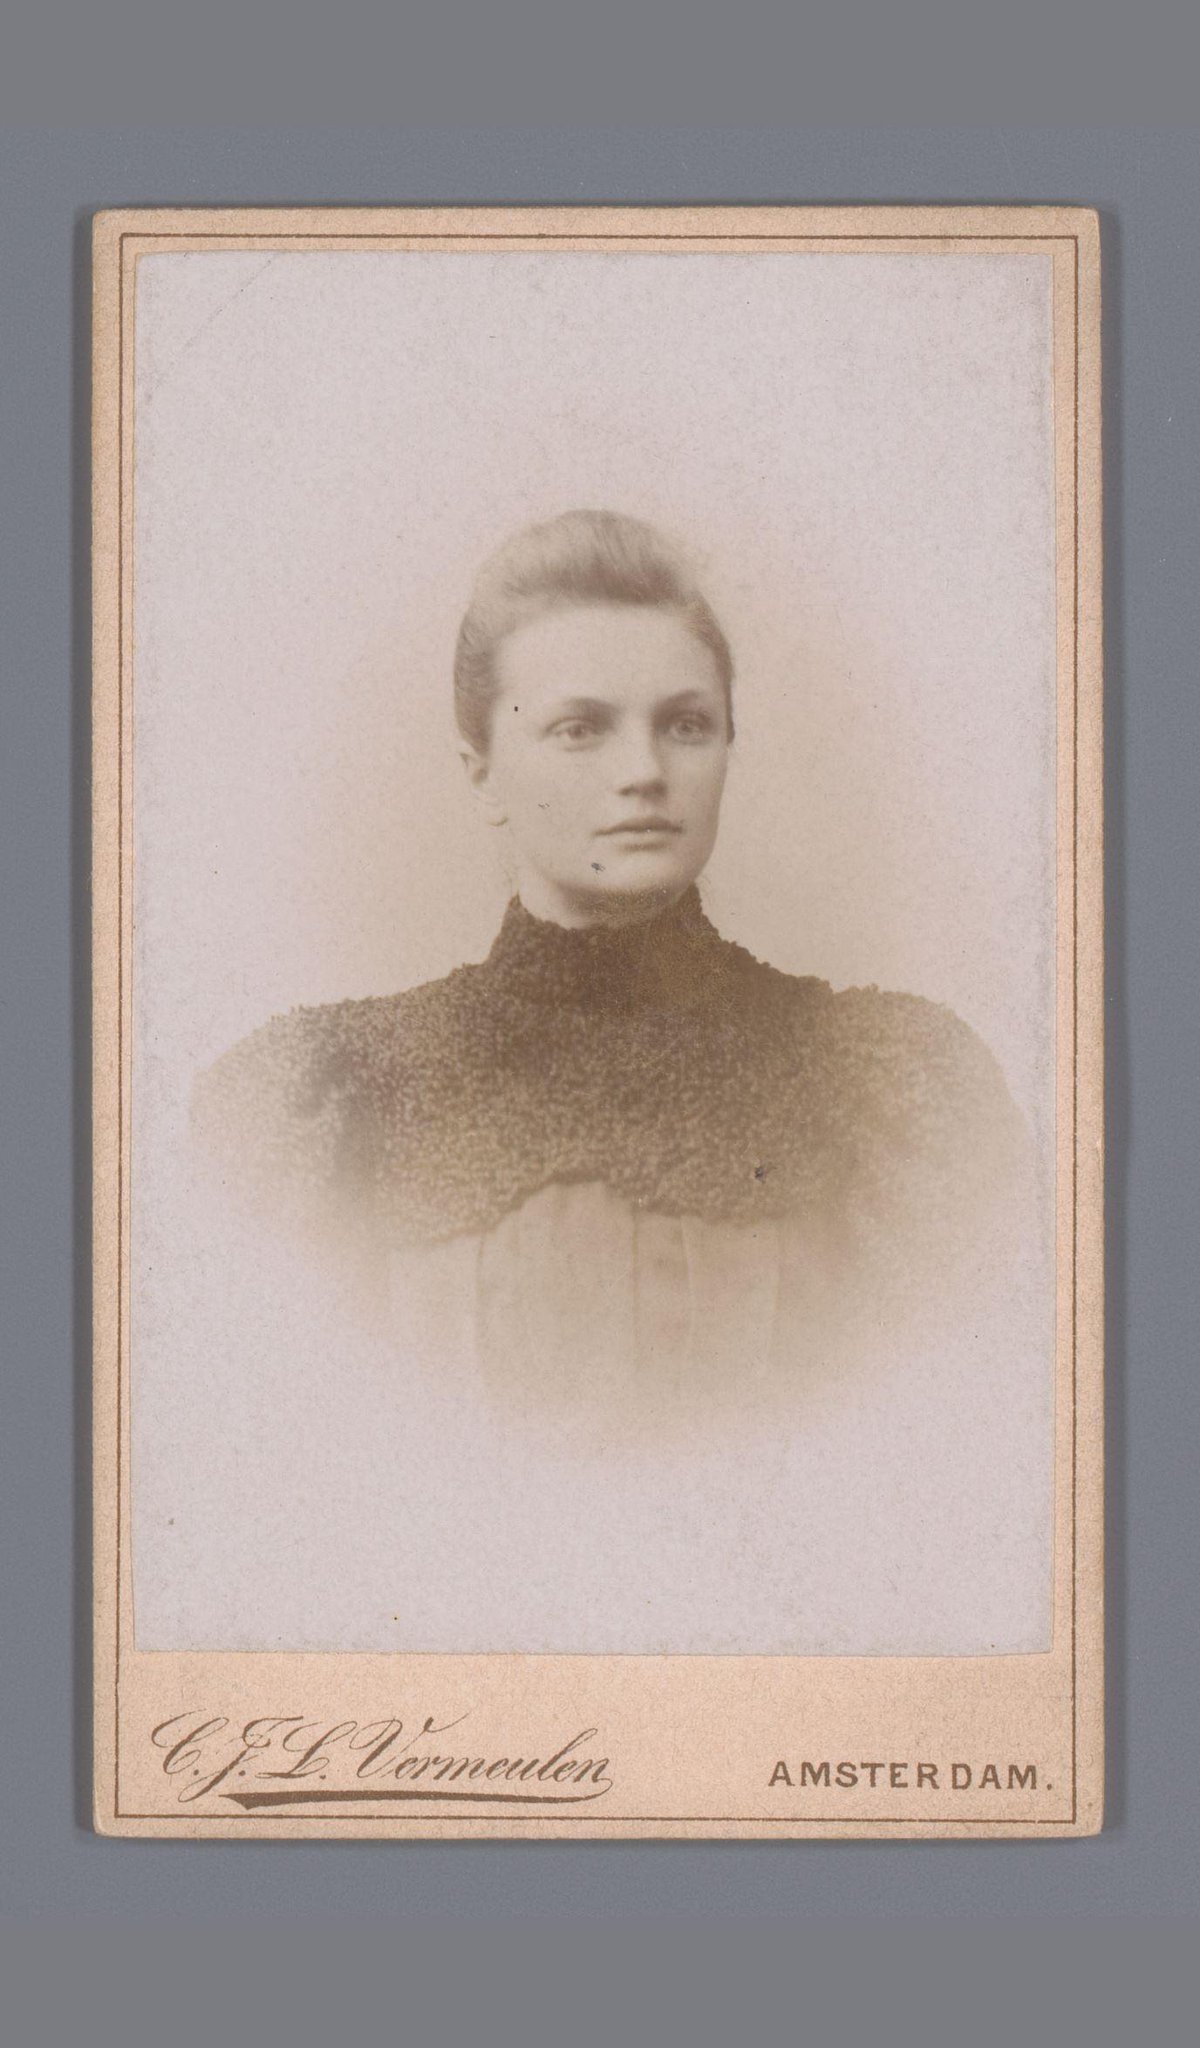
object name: photograph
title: Portret van Jacqueline E. van der Waals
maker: cornelis johannes lodewicus vermeulen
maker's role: fotograaf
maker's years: 1861-1936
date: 1890-1915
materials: cardboard, photographic support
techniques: collodion silver print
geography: amsterdam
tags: the hague, historical persons, amsterdam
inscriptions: workshop stamp: ‘Photographische Ateliers/ C.J.L. Vermeulen/ Heerenstraat 6, Heiligenweg hoe Singel, Amsterdam’